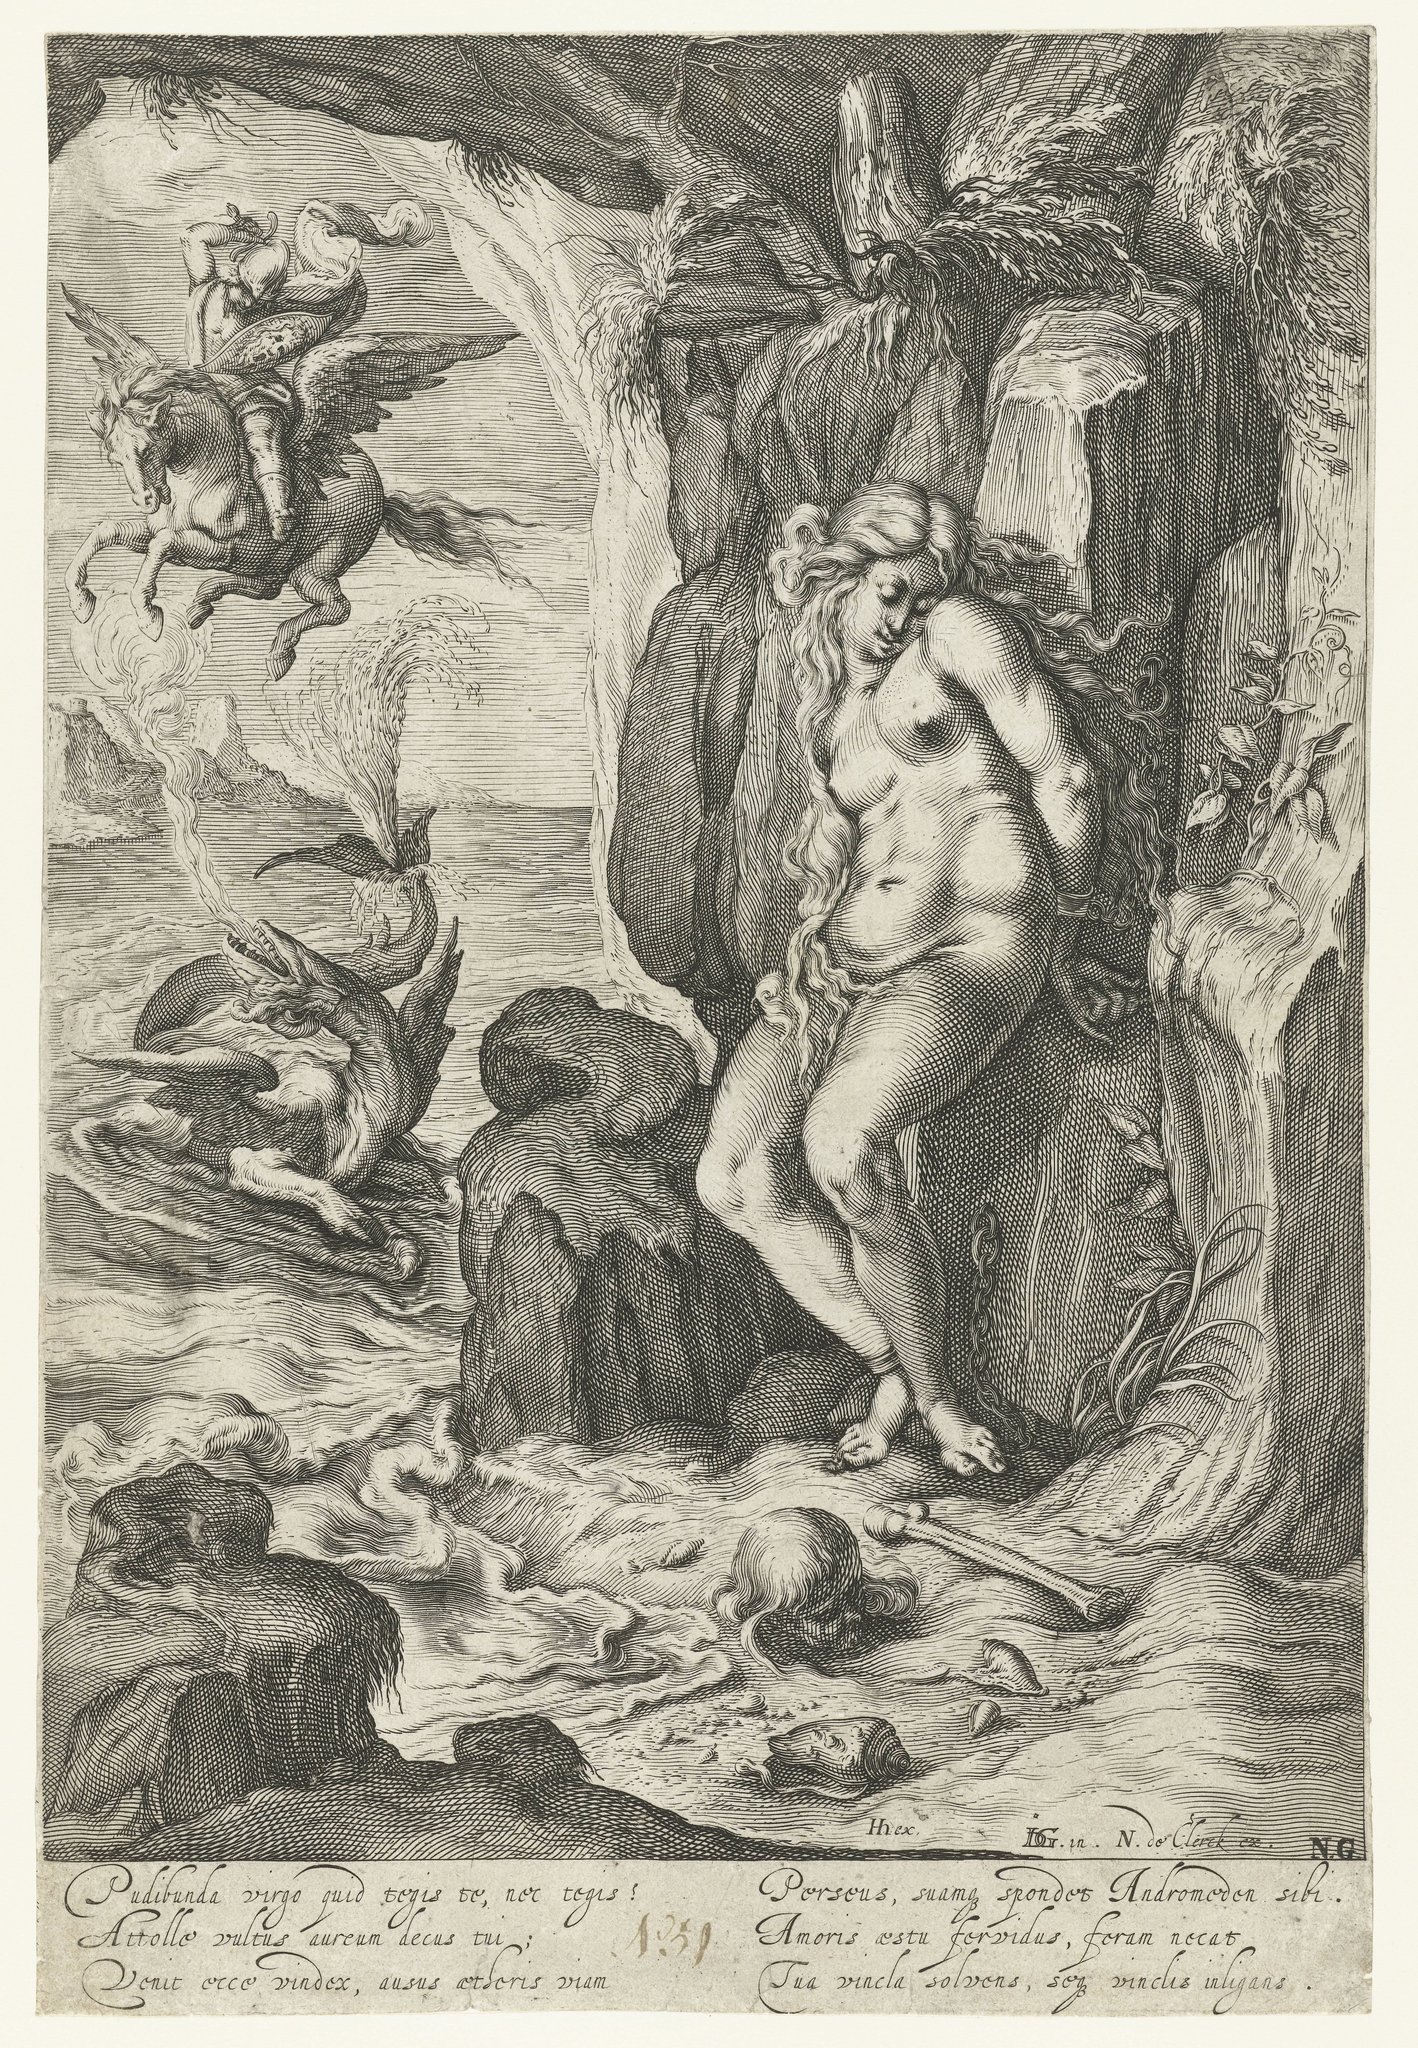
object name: print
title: Perseus bevrijdt Andromeda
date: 1608-1612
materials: paper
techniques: engraving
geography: delft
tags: perseus and andromeda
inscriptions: inscription: ‘N12’, inscription: ‘N59’, collector's mark: Lugt 2228a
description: Perseus komt op een gevleugeld paard aangestormd om het zeemonster te doden dat Andromeda, aan een rots gekluisterd, bedreigt. Onder de voorstelling twee drieregelige Latijnse coupletten.